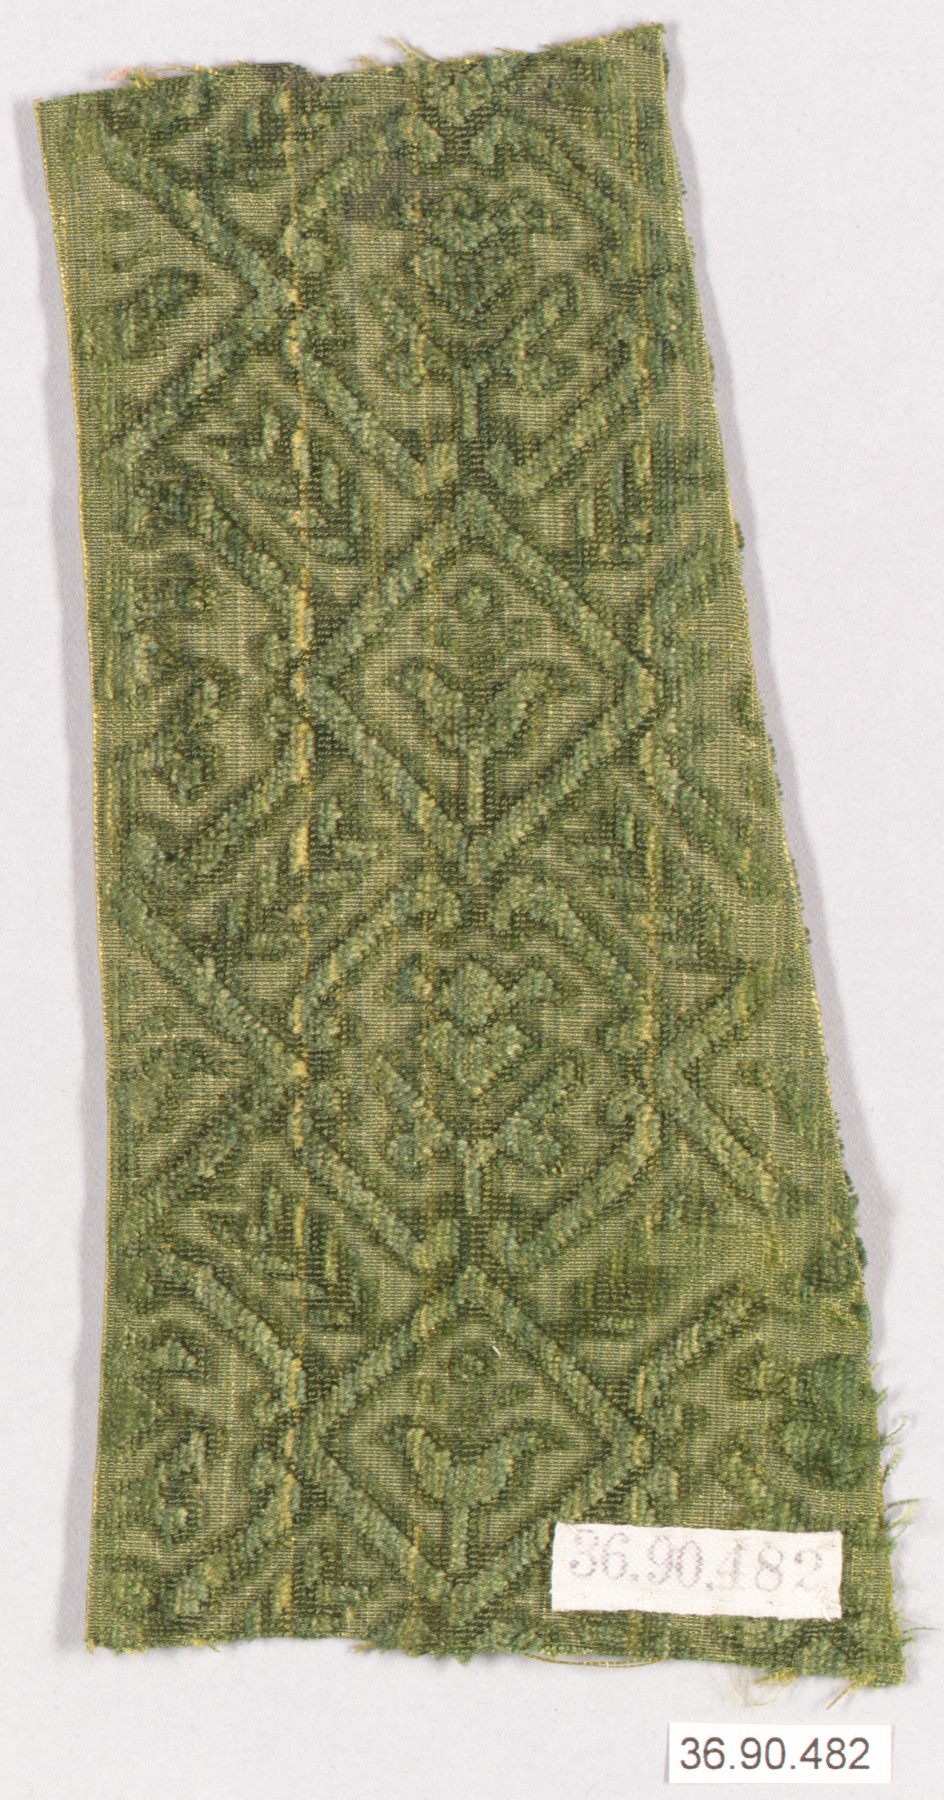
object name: piece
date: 1501-1700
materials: silk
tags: birds